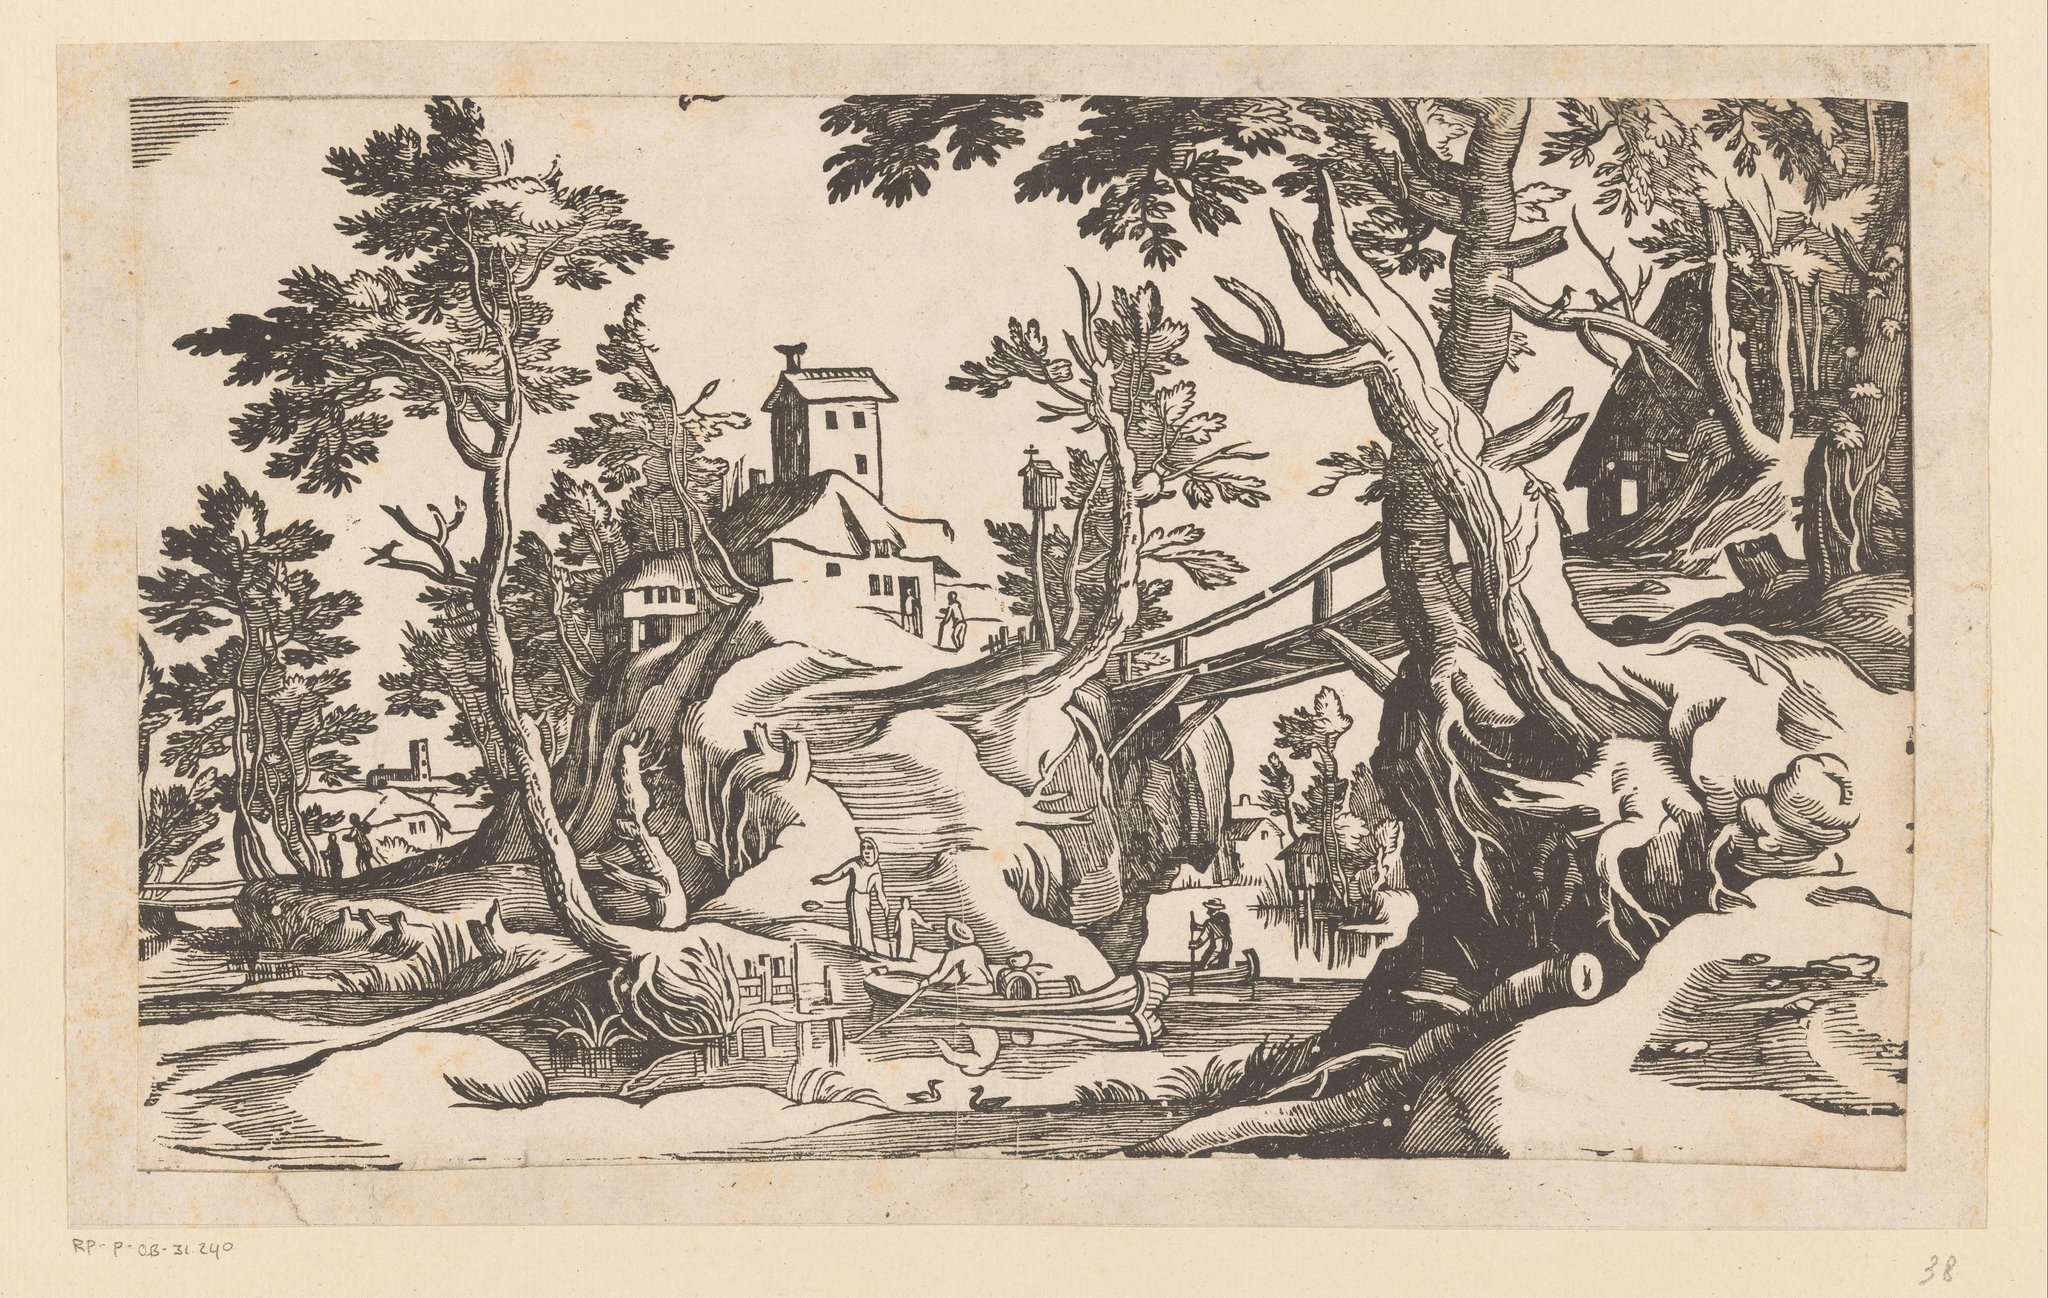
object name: print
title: Rivierlandschap met brug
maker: Anonymous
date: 1500-1599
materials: paper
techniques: woodcut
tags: river, landscape with bridge, viaduct or aqueduct, rowing-boat, canoe, etc.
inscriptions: collector's mark: Lugt 240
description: Landschap met een brug en roeiboten op een rivier.